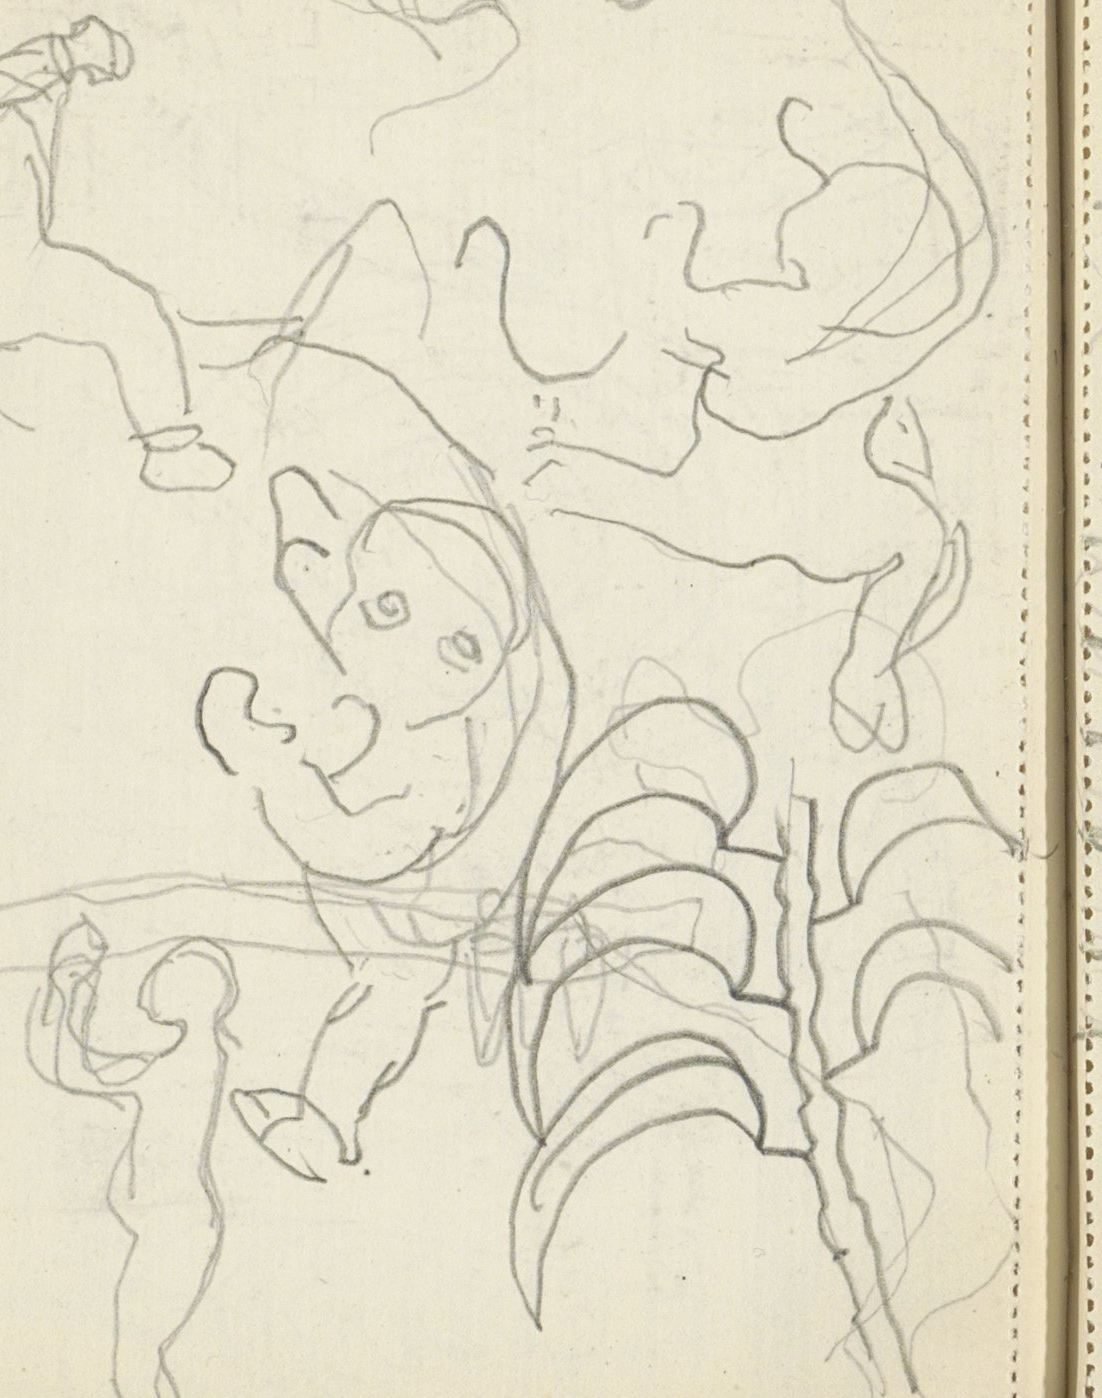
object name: sketchbook leaf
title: Vrouwen met baby's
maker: reijer stolk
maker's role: draughtsman, print maker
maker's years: 1896-1945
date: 1916-1945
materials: paper, pencil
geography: africa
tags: feeding a baby, infant, baby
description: Studies van de baby aan de borst en van een vrouw die een baby optilt. Blad 53 verso uit een schetsboek met 60 bladen.